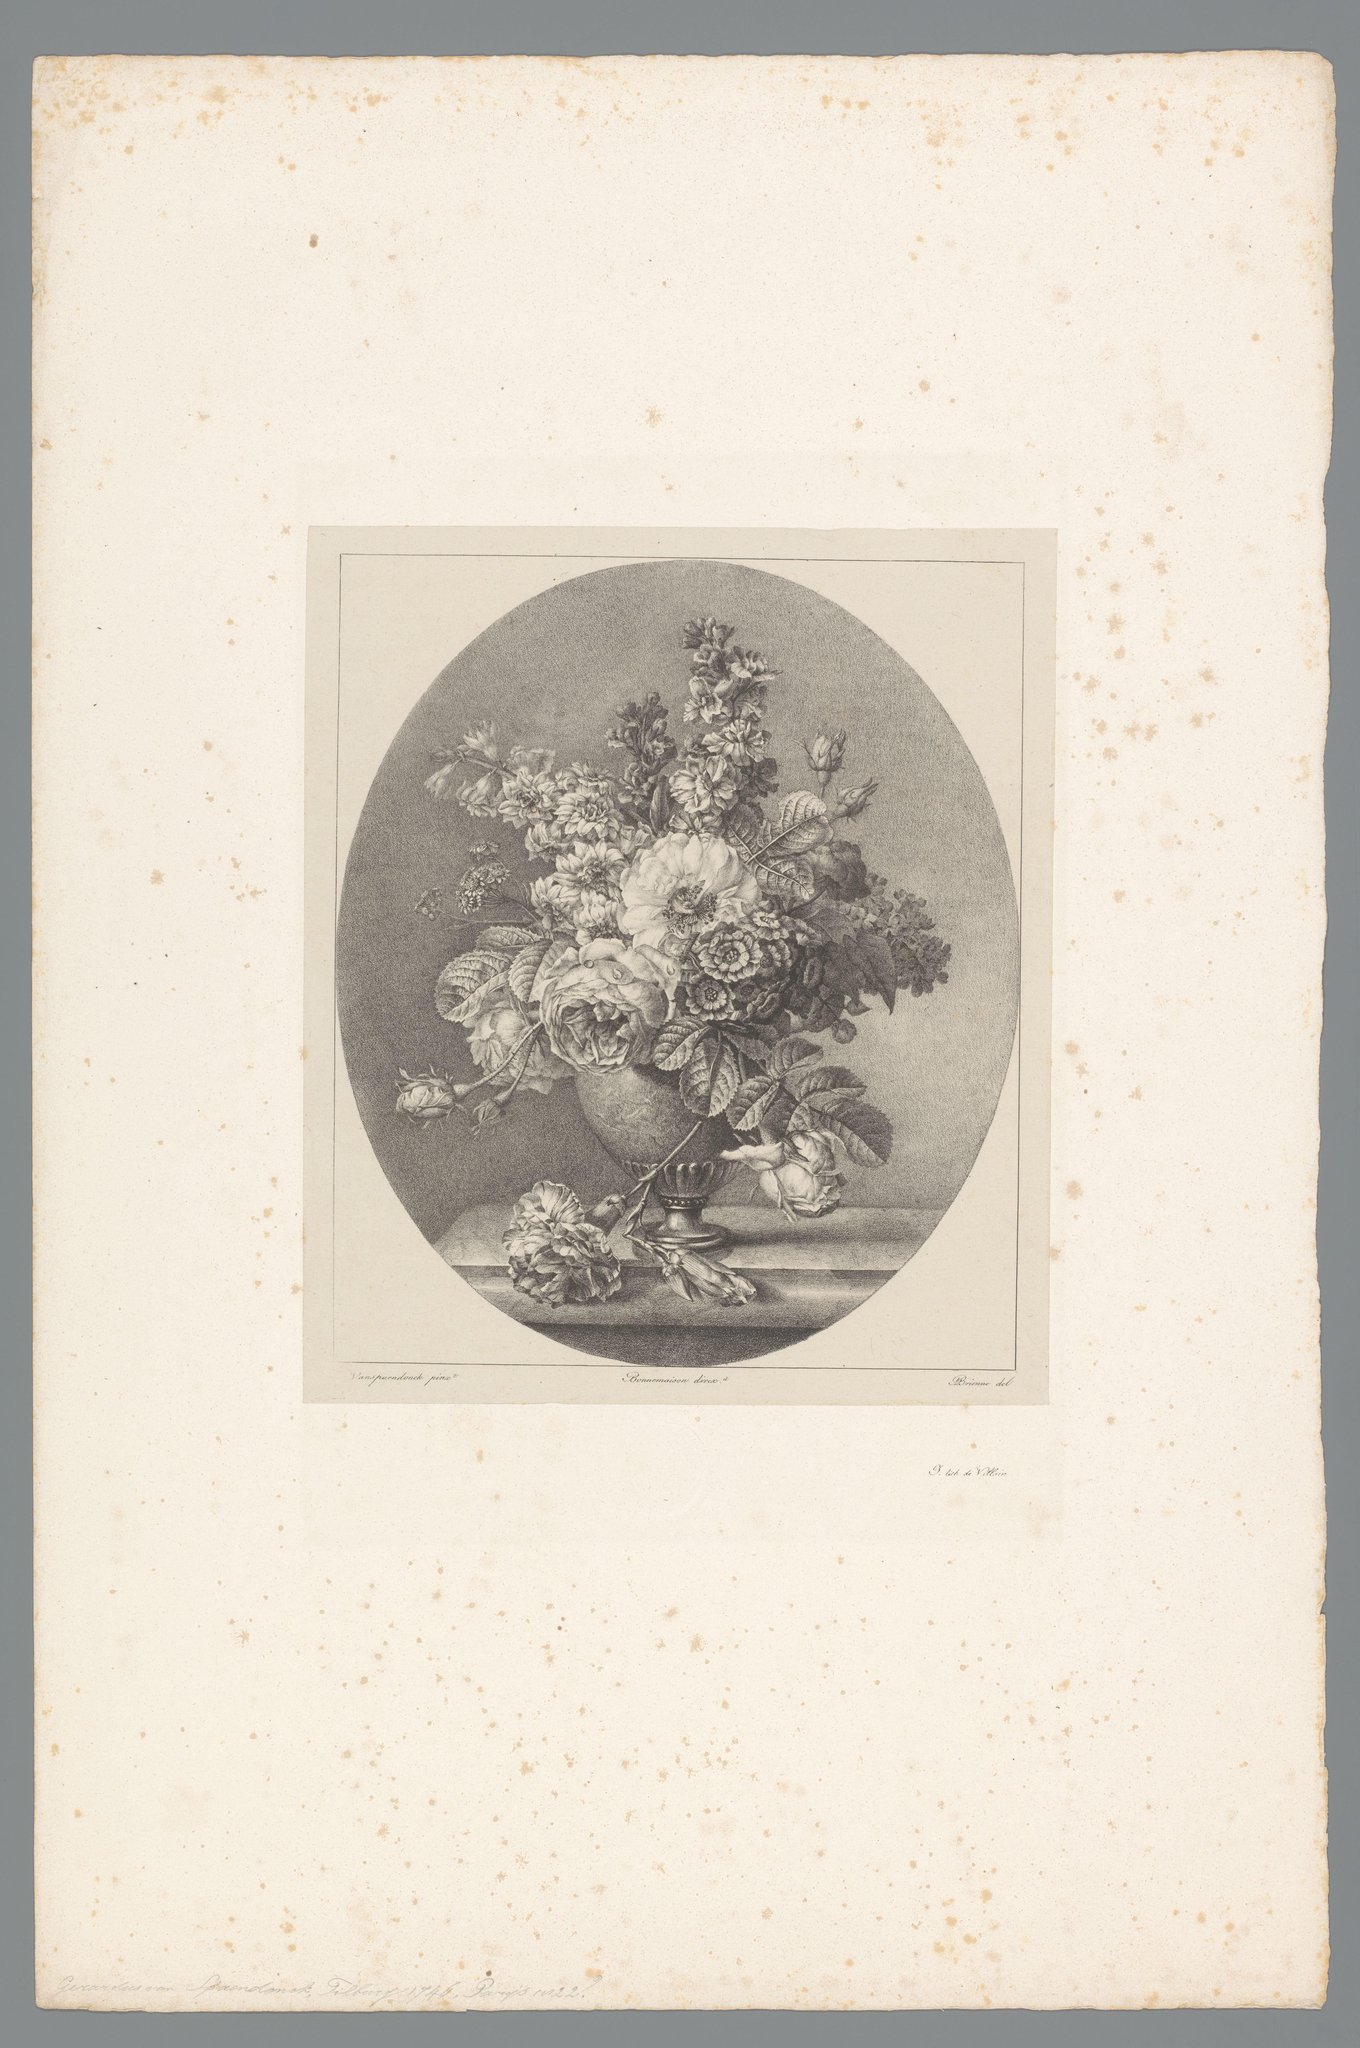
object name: print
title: Stilleven van bloemen in een vaas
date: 1818-1826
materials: paper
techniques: lithograph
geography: paris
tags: cut flowers; nosegay, bunch of flowers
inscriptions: check stamp: Lugt 4729